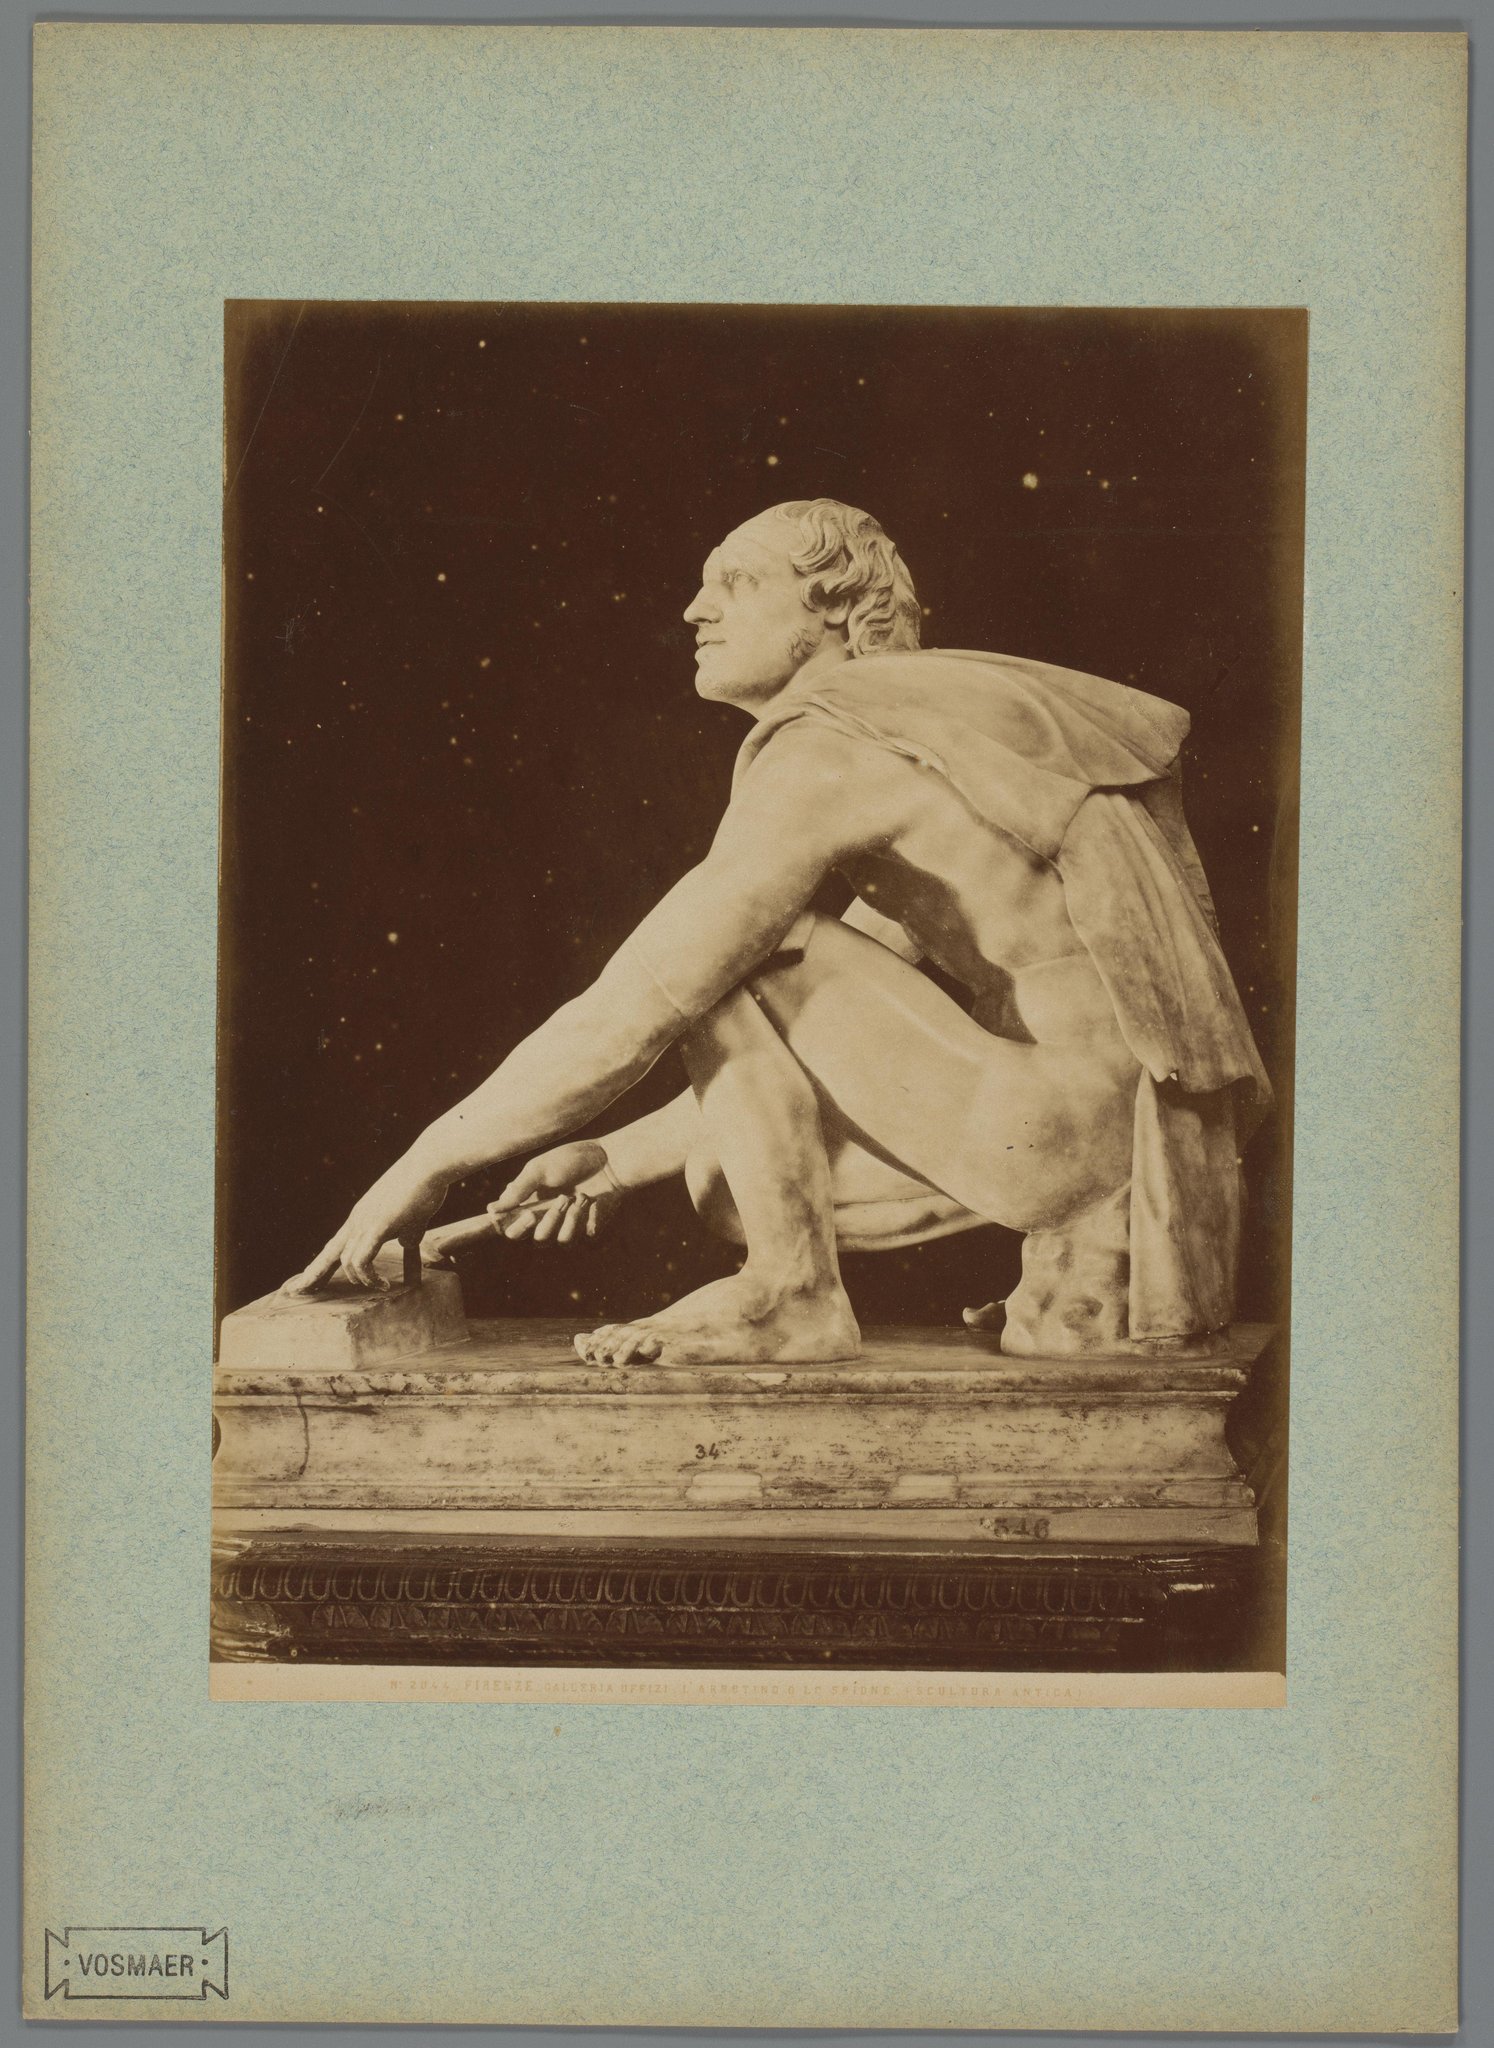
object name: photograph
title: Sculptuur van Arrotino in de Galleria degli Uffizi te Florence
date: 1852-1900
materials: cardboard, paper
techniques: albumen print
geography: florence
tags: piece of sculpture, reproduction of a piece of sculpture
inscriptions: number: ‘No. 2044.’, collector's mark: ‘VOSMAER’